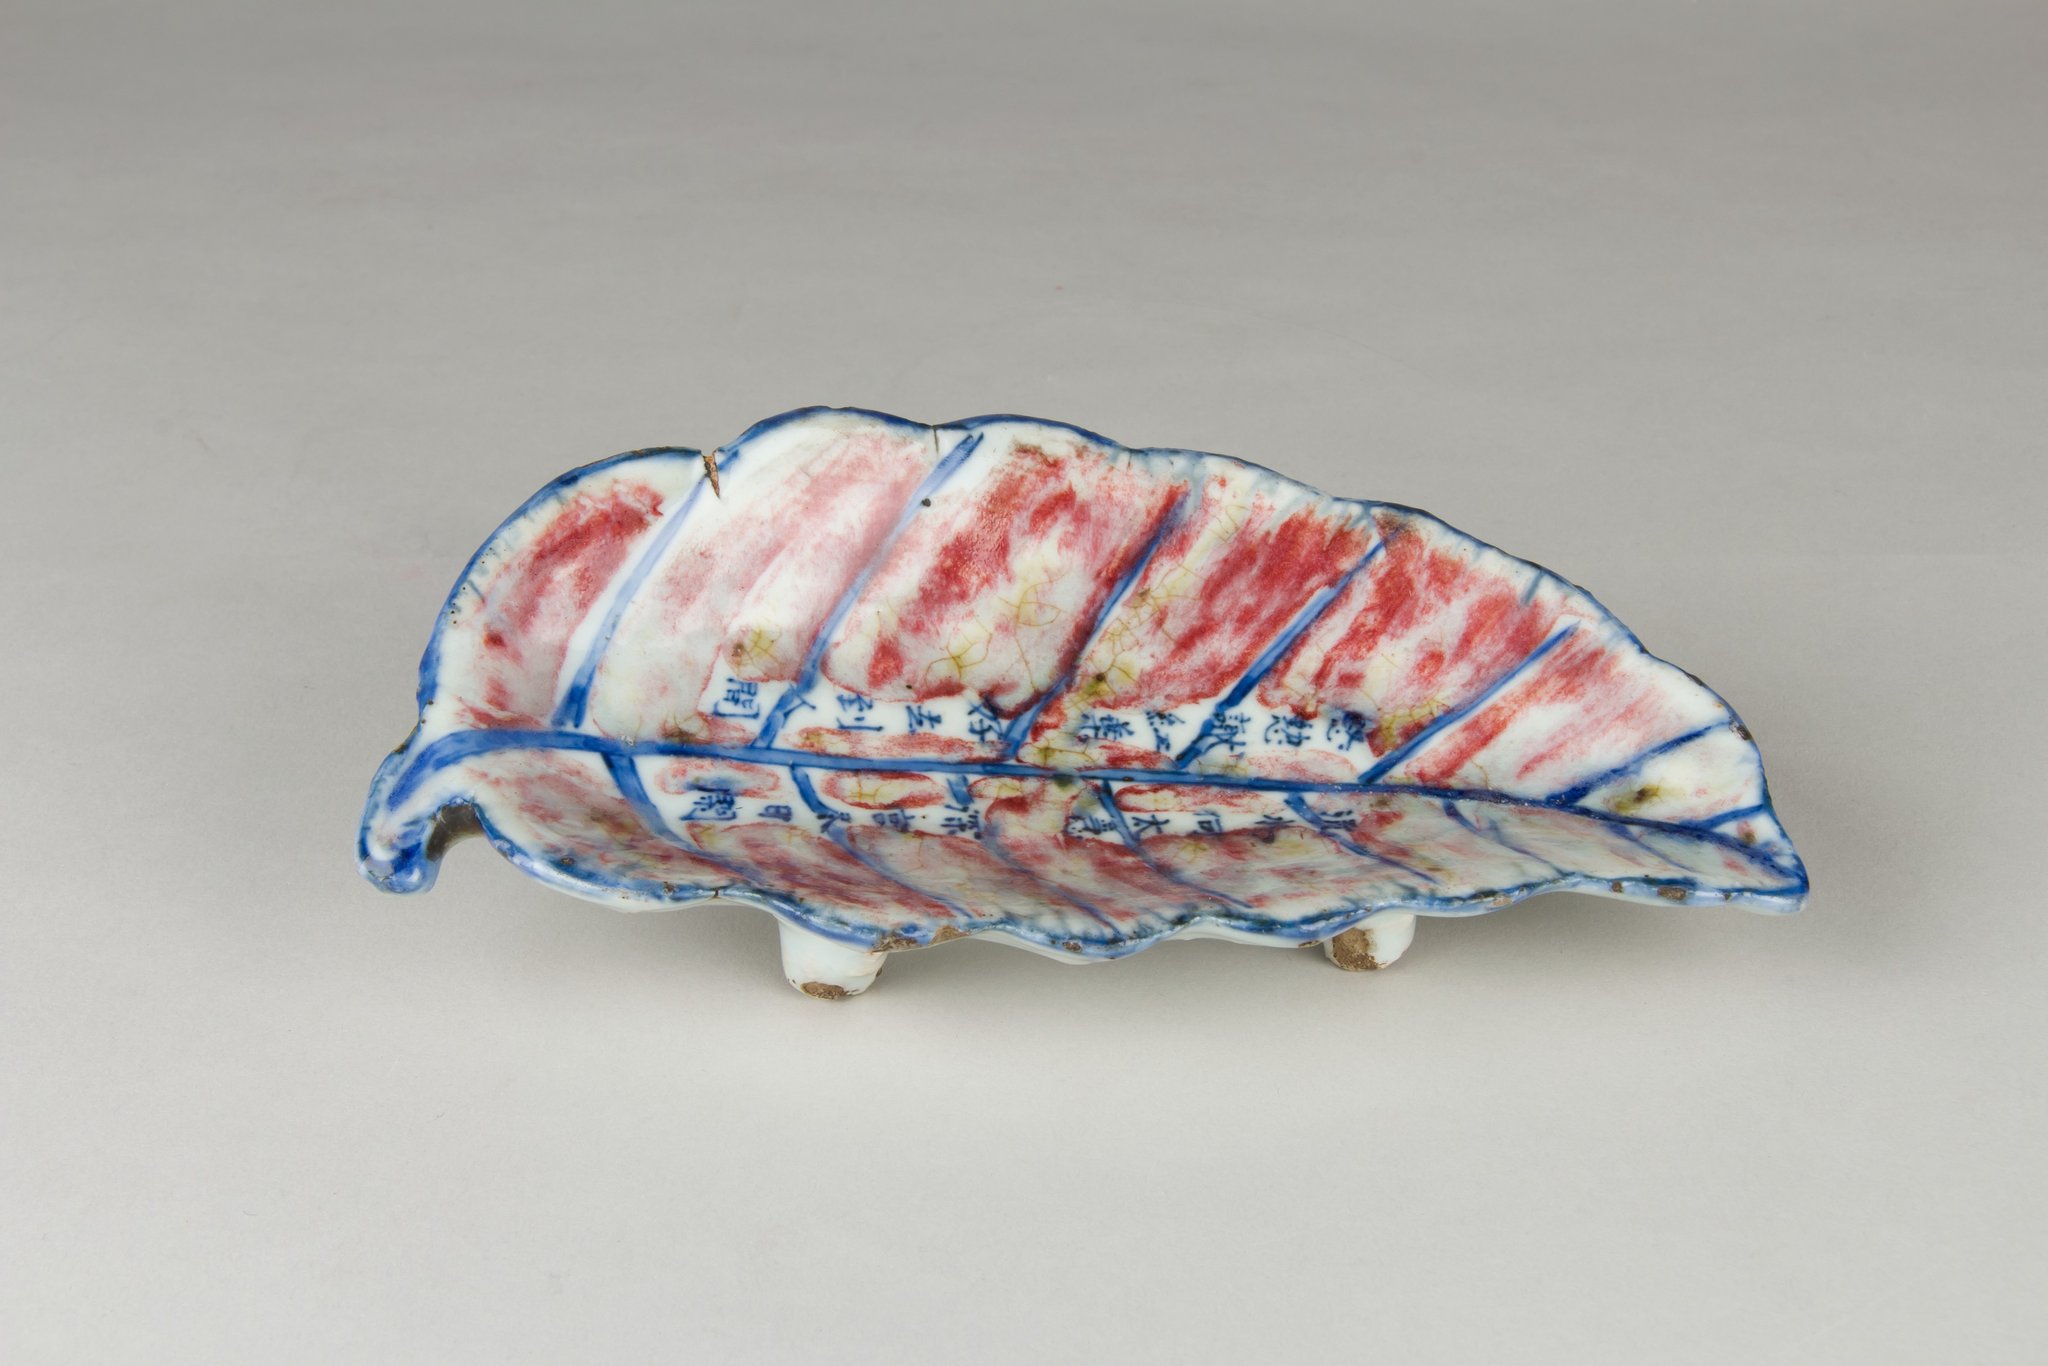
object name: dish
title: Leaf-shaped dish with poem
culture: chinese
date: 1601-1650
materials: cobalt, copper, porcelain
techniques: painting, underglaze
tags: leaves